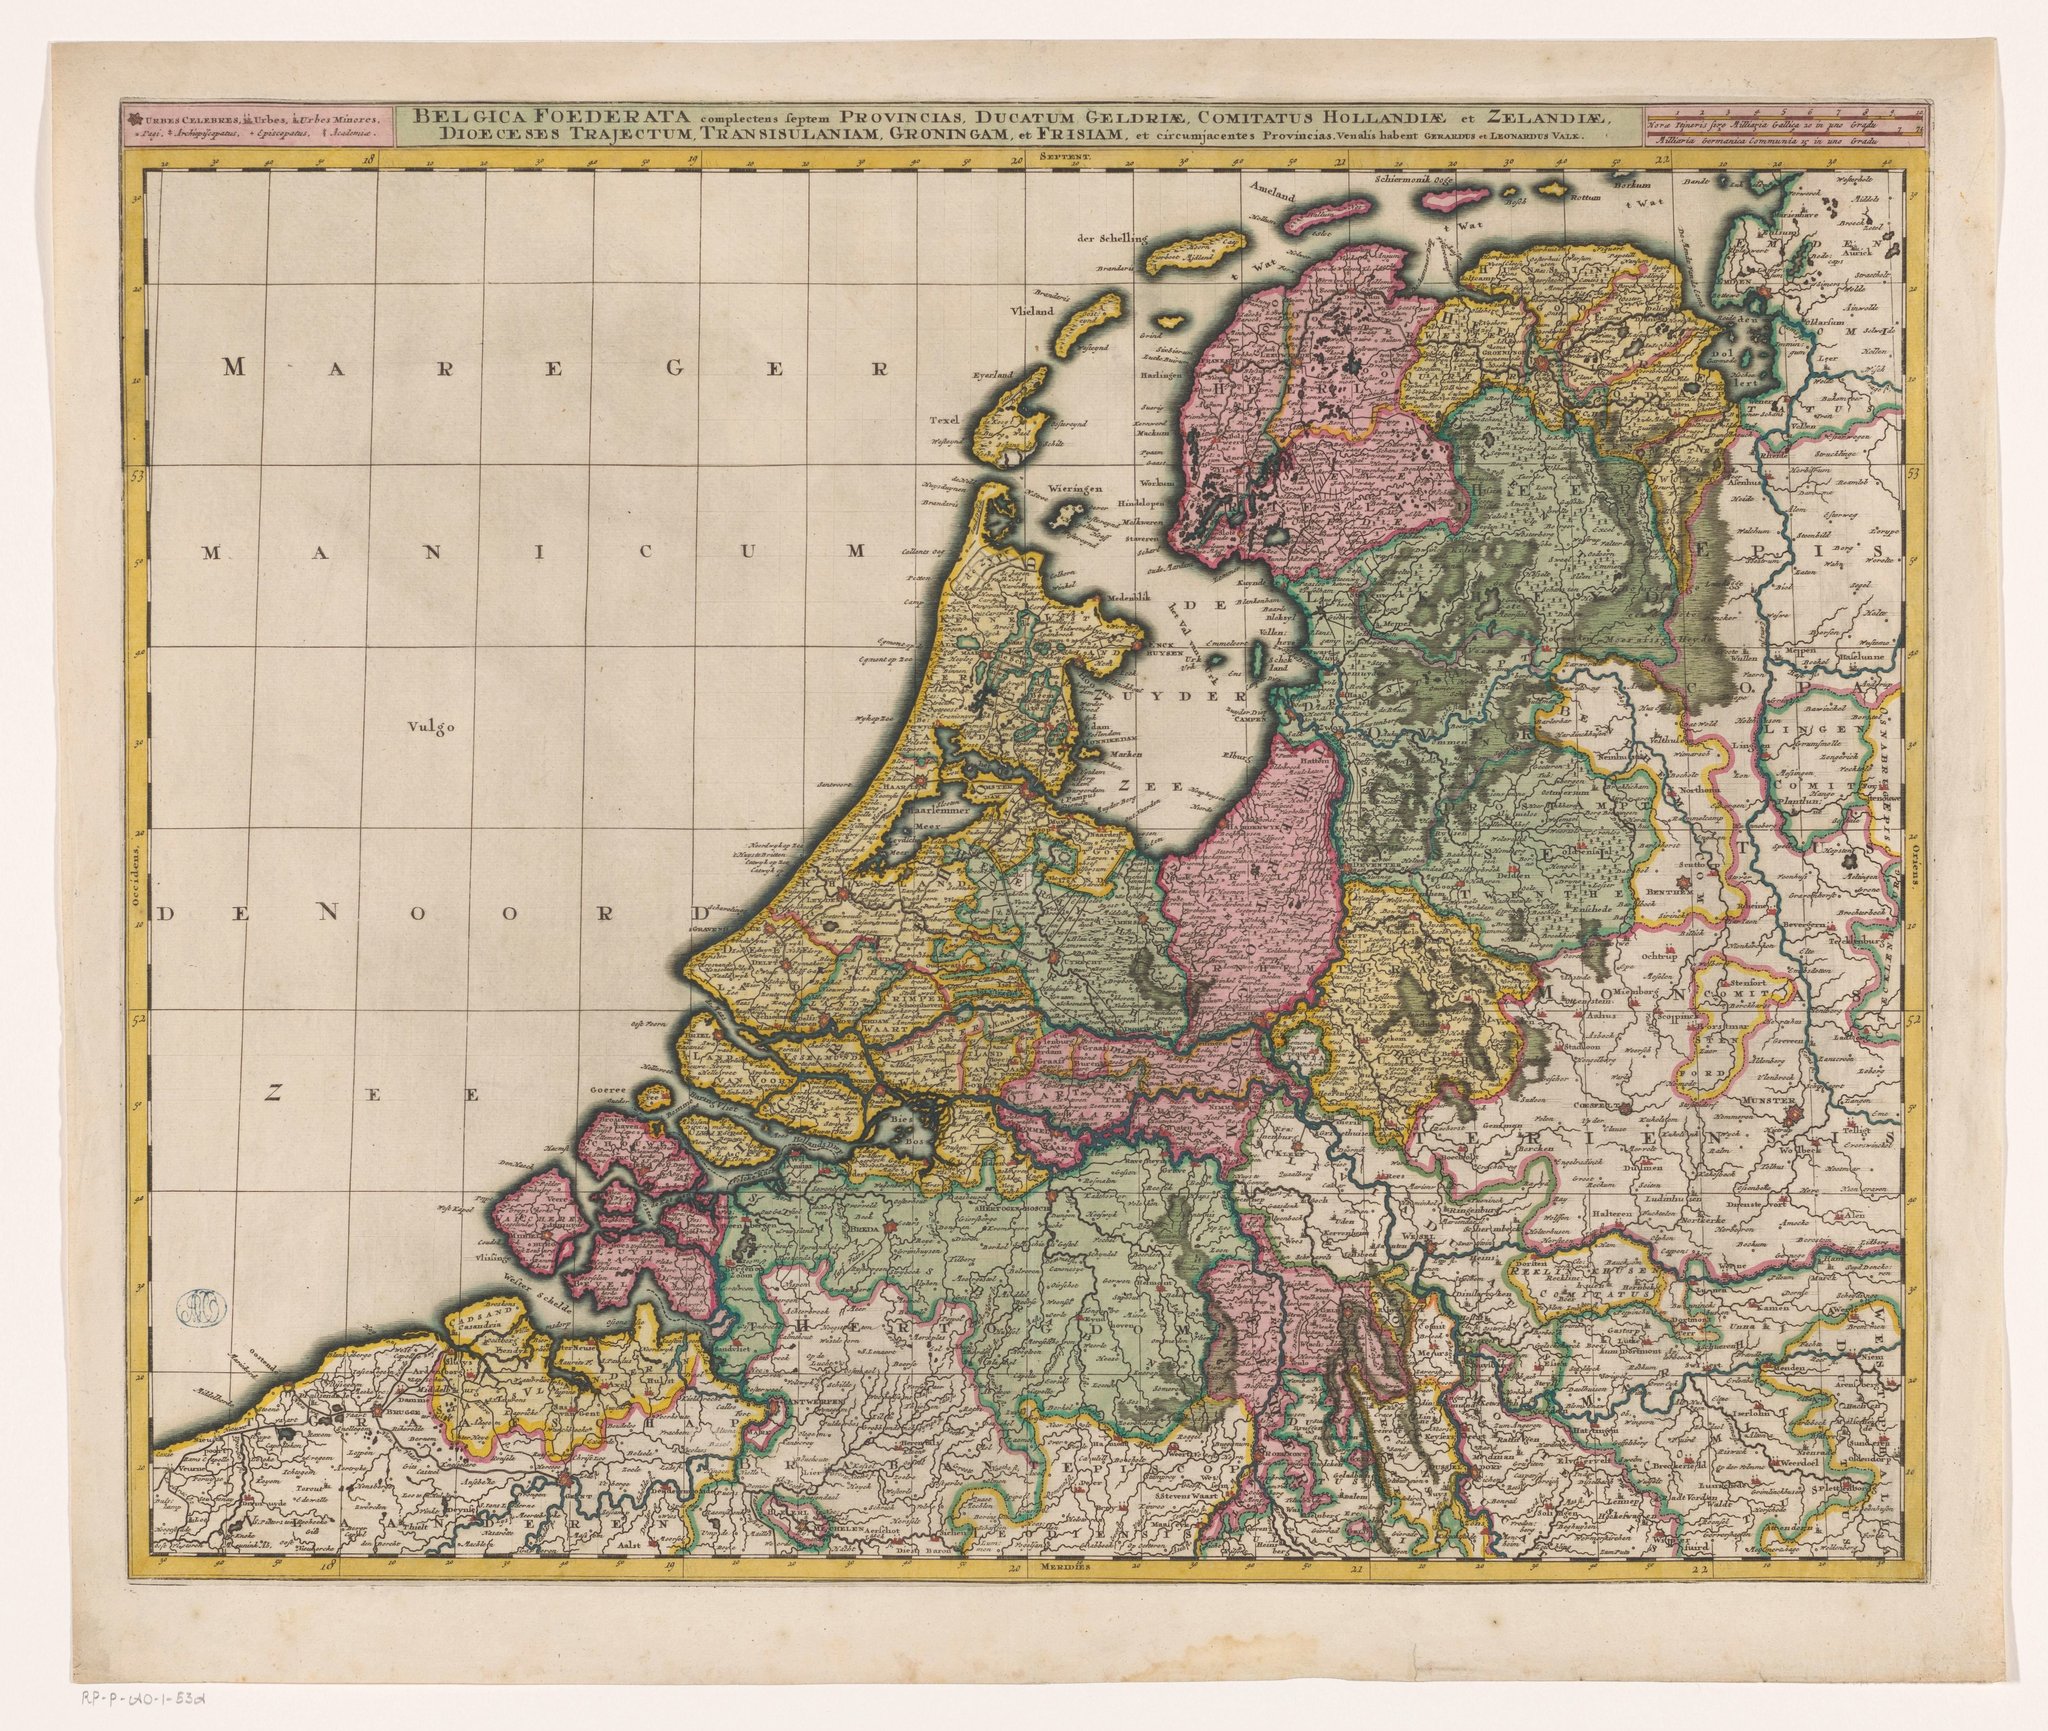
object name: print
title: Kaart van de Republiek der Zeven Verenigde Nederlanden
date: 1702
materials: paper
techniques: engraving, hand coloring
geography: amsterdam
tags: maps of separate countries or regions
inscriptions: collector's mark: Lugt 2228, collector's mark: Lugt 195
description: Linksboven legenda. Rechtsboven schaalstok: Hore itineris sive milliaria Gallica 20 in uno gradu, Milliaria Germanica communia 15 in uno gradu. De prent is voorzien van een coördinaten-net en een gradenverdeling langs de randen.